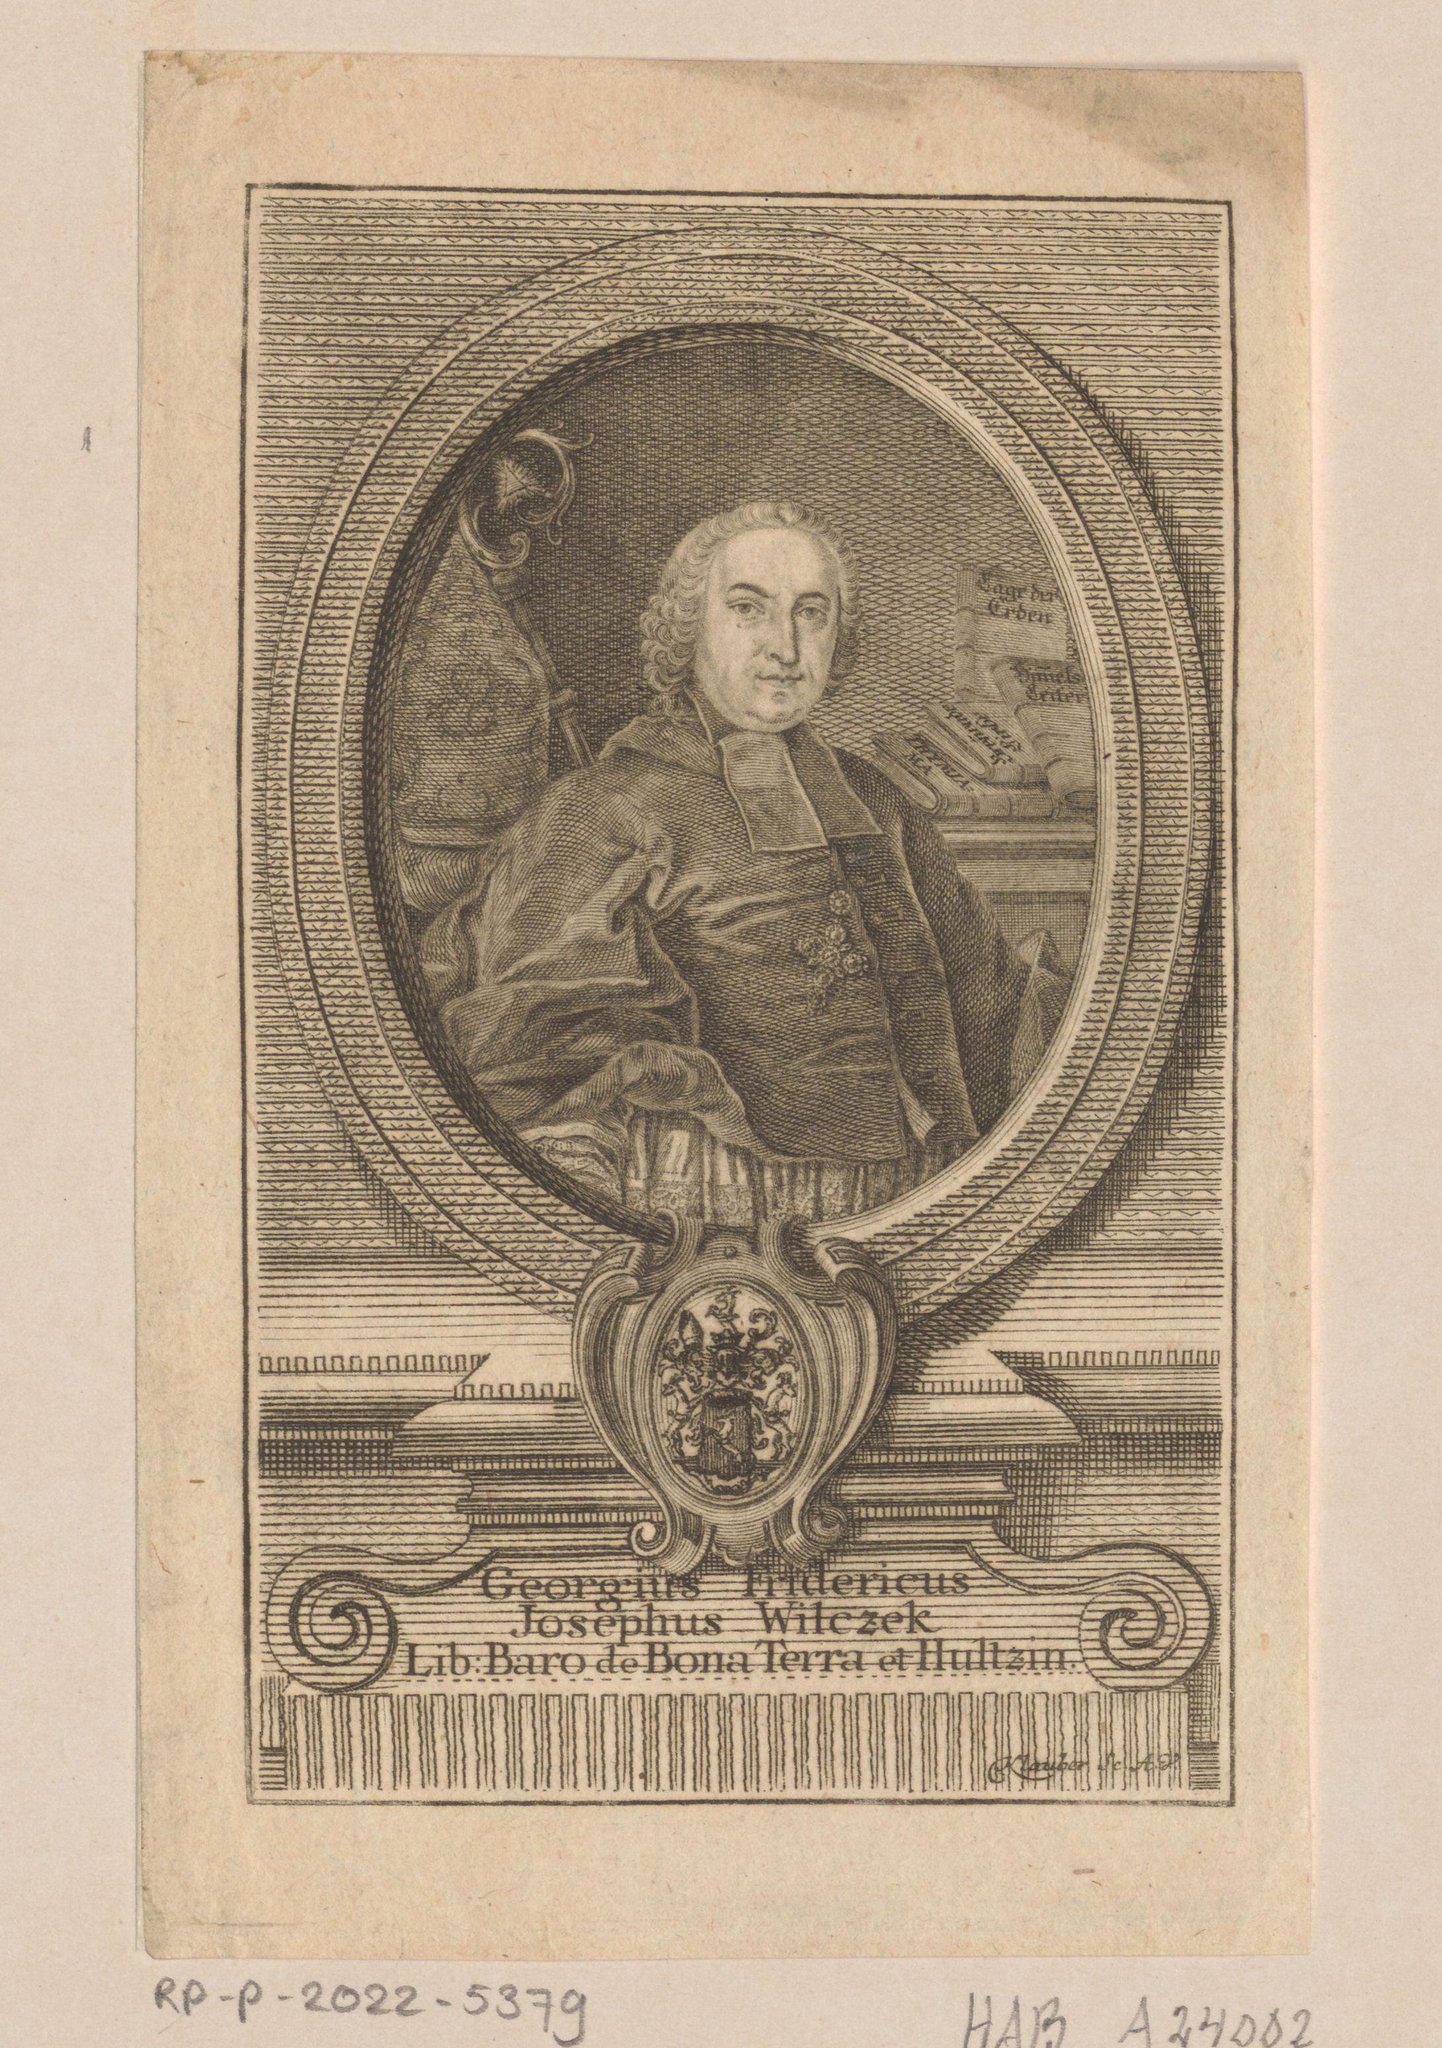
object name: print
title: Portret van Georg Friedrich Joseph Wilczek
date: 1710-1835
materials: paper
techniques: engraving, etching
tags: historical persons